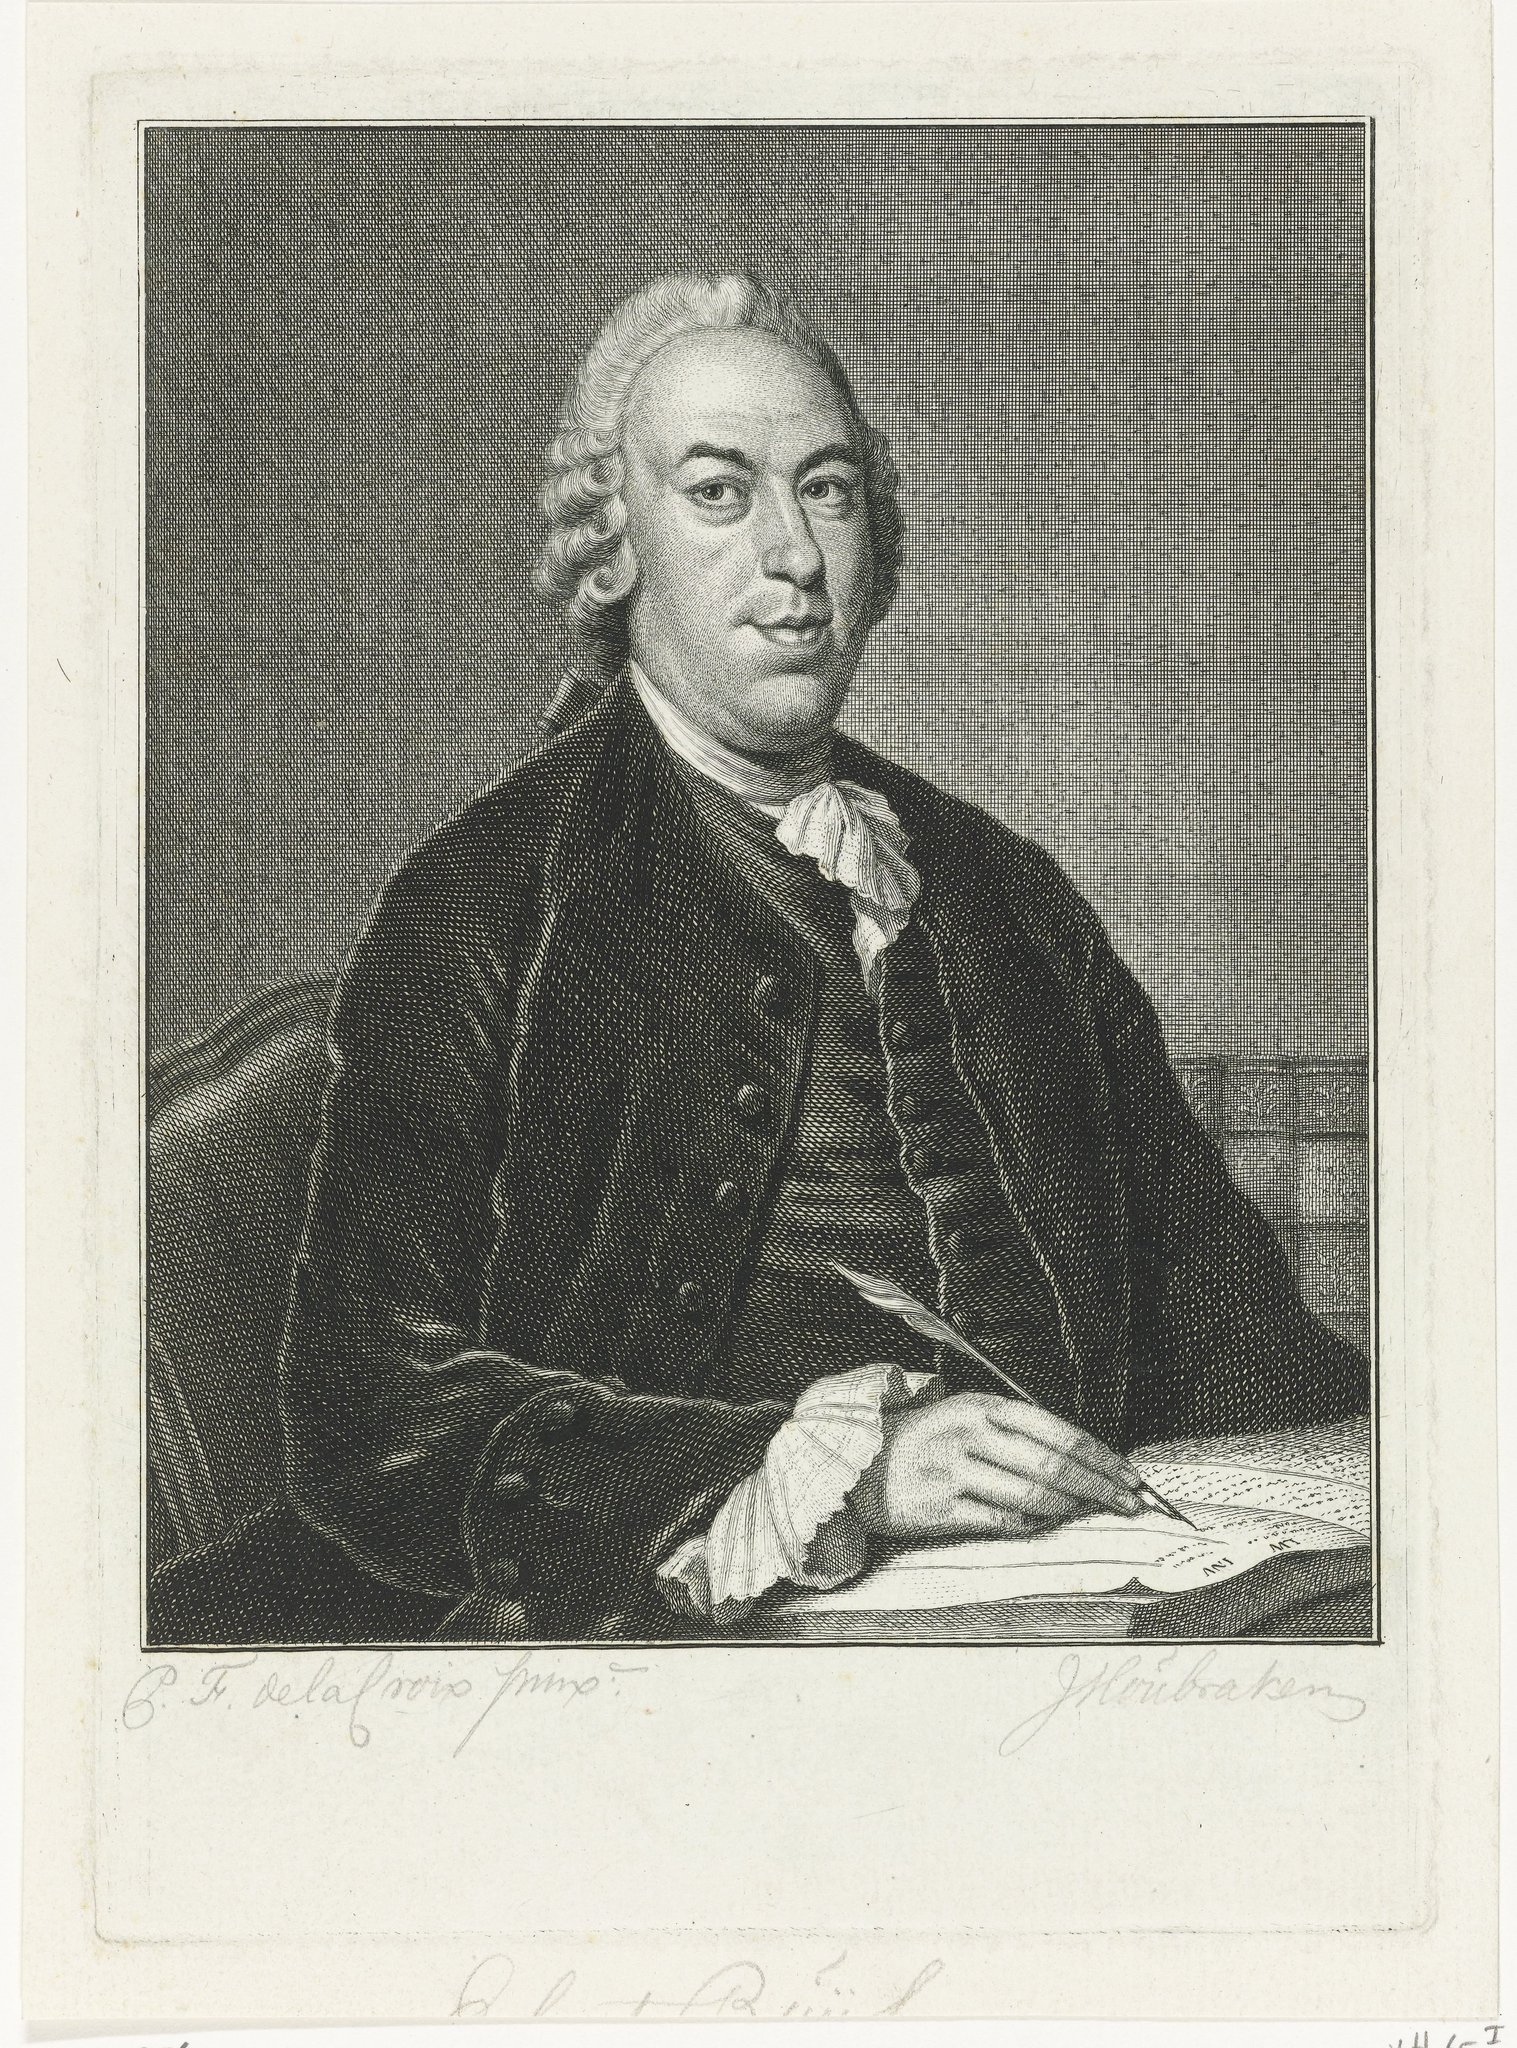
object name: print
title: Portret van Egbert Buys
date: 1764-1777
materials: paper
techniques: engraving, etching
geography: amsterdam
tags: schrijver, egbert buys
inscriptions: collector's mark: Lugt 2228, inscription: ‘P.F. delaCroix Pinx.’, inscription: ‘J.Houbraken’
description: Portret ten halven lijve van Egbert Buys, schrijvend aan een tafel.